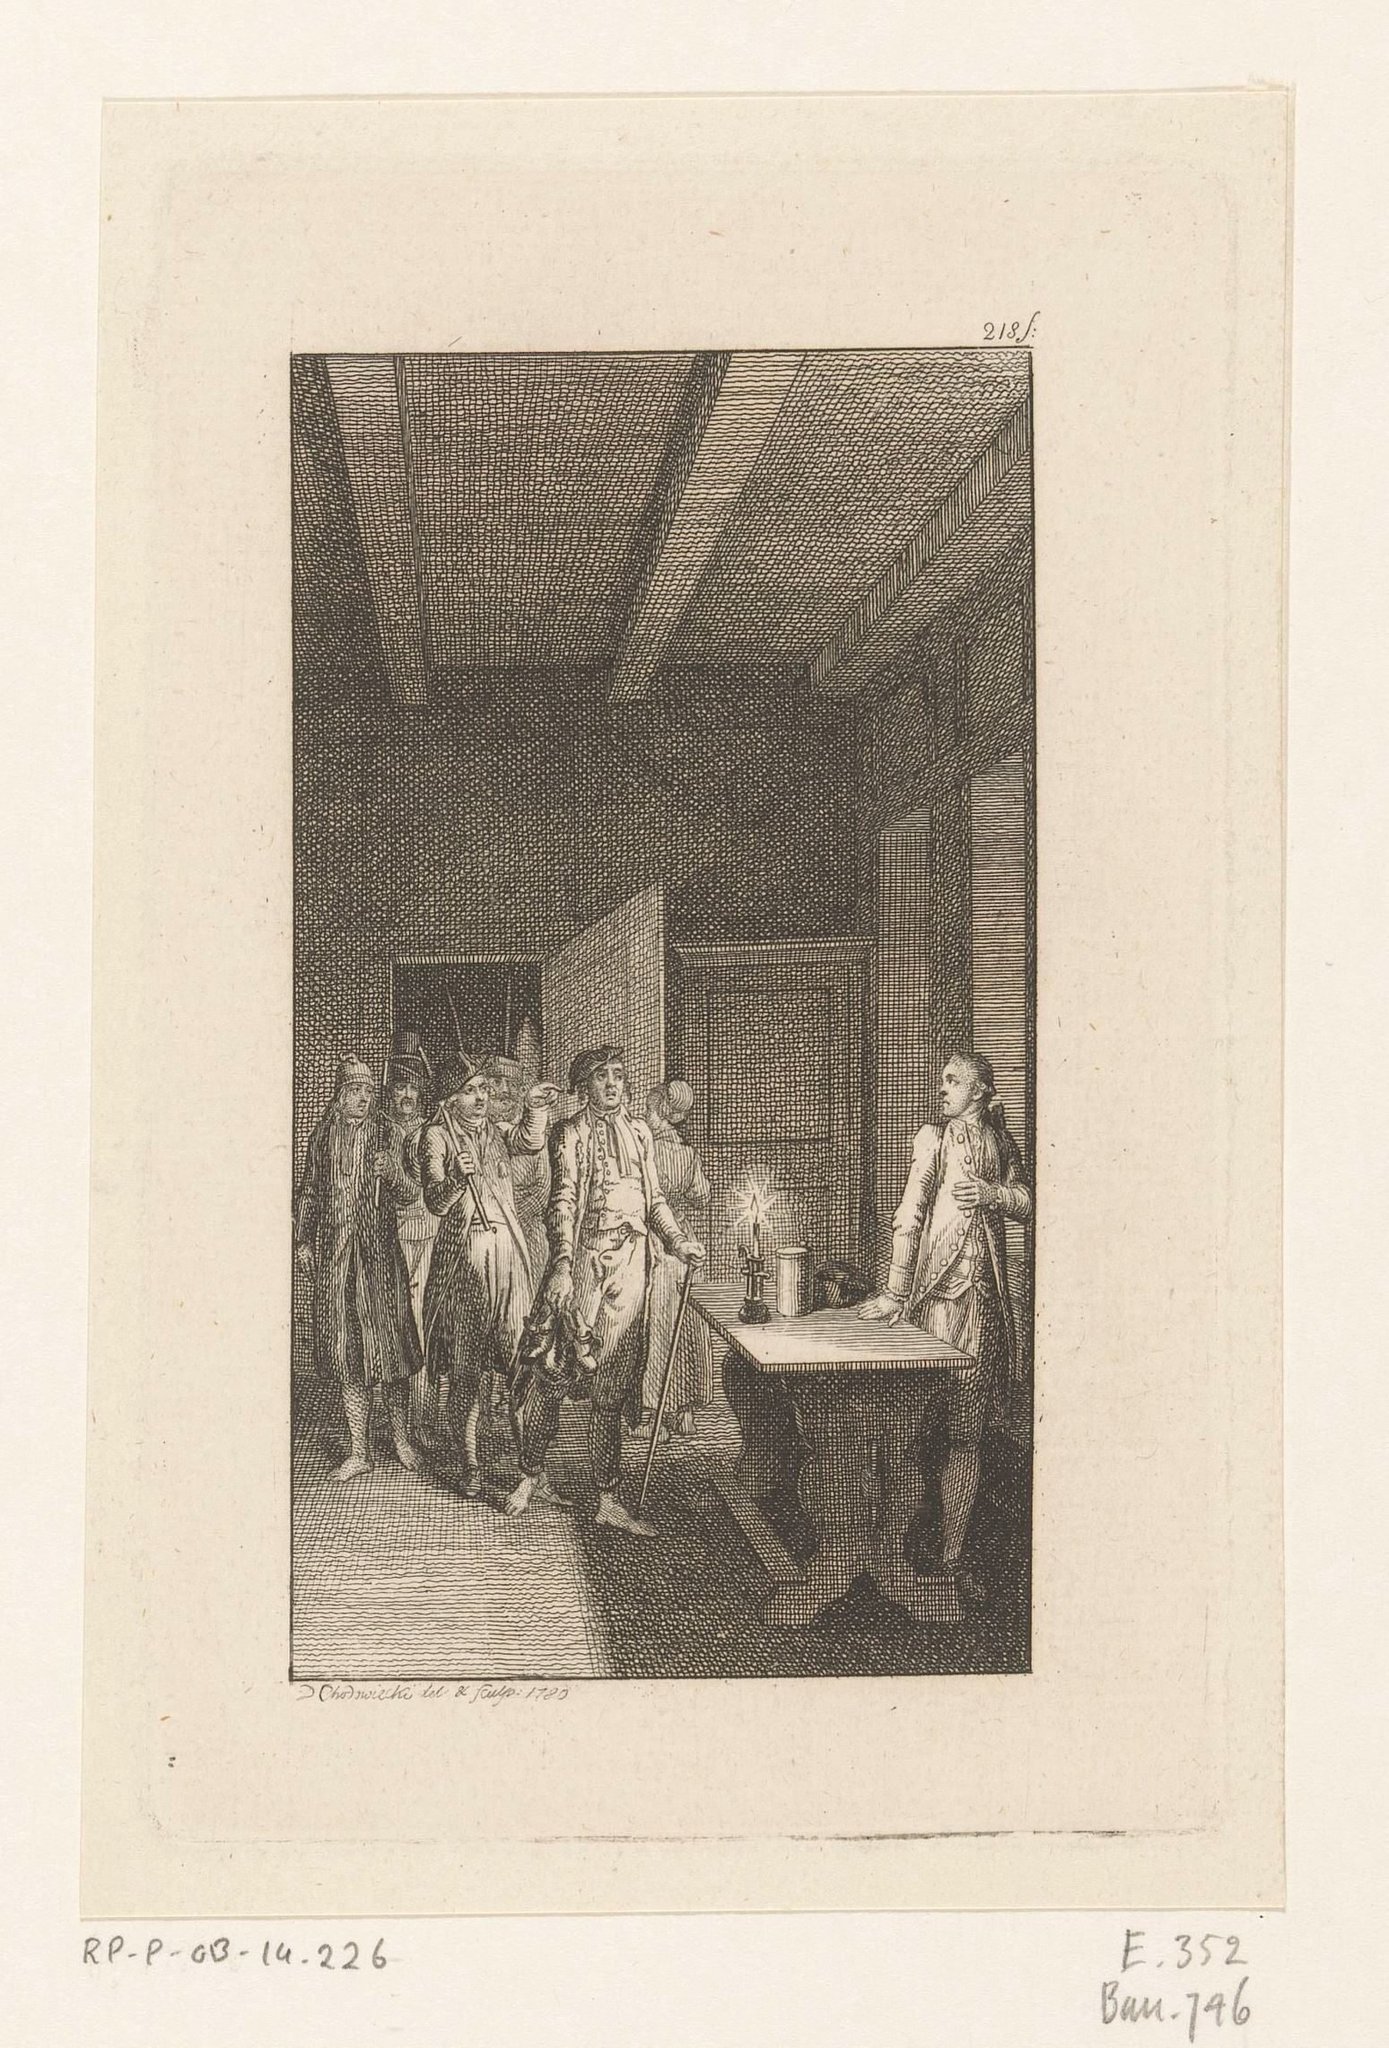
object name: print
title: Wilhelm Edelwald wordt aangehouden omdat hij geen paspoort kan overhandigen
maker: daniel nikolaus chodowiecki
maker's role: draughtsman, print maker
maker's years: 1726-1801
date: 1780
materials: paper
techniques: etching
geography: berlin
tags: table, candle, interior of the house, index finger forwards, pointing, indicating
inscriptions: collector's mark: Lugt 2228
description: Prent gebruikt voor: Westphal, Georg Christian von. Wilhelm Edelwald die Geschichte eines verlohrenen Sohnes. 2 dln. Leipzig: Weygandschen Buchhandlung, 1780, dl. 1.